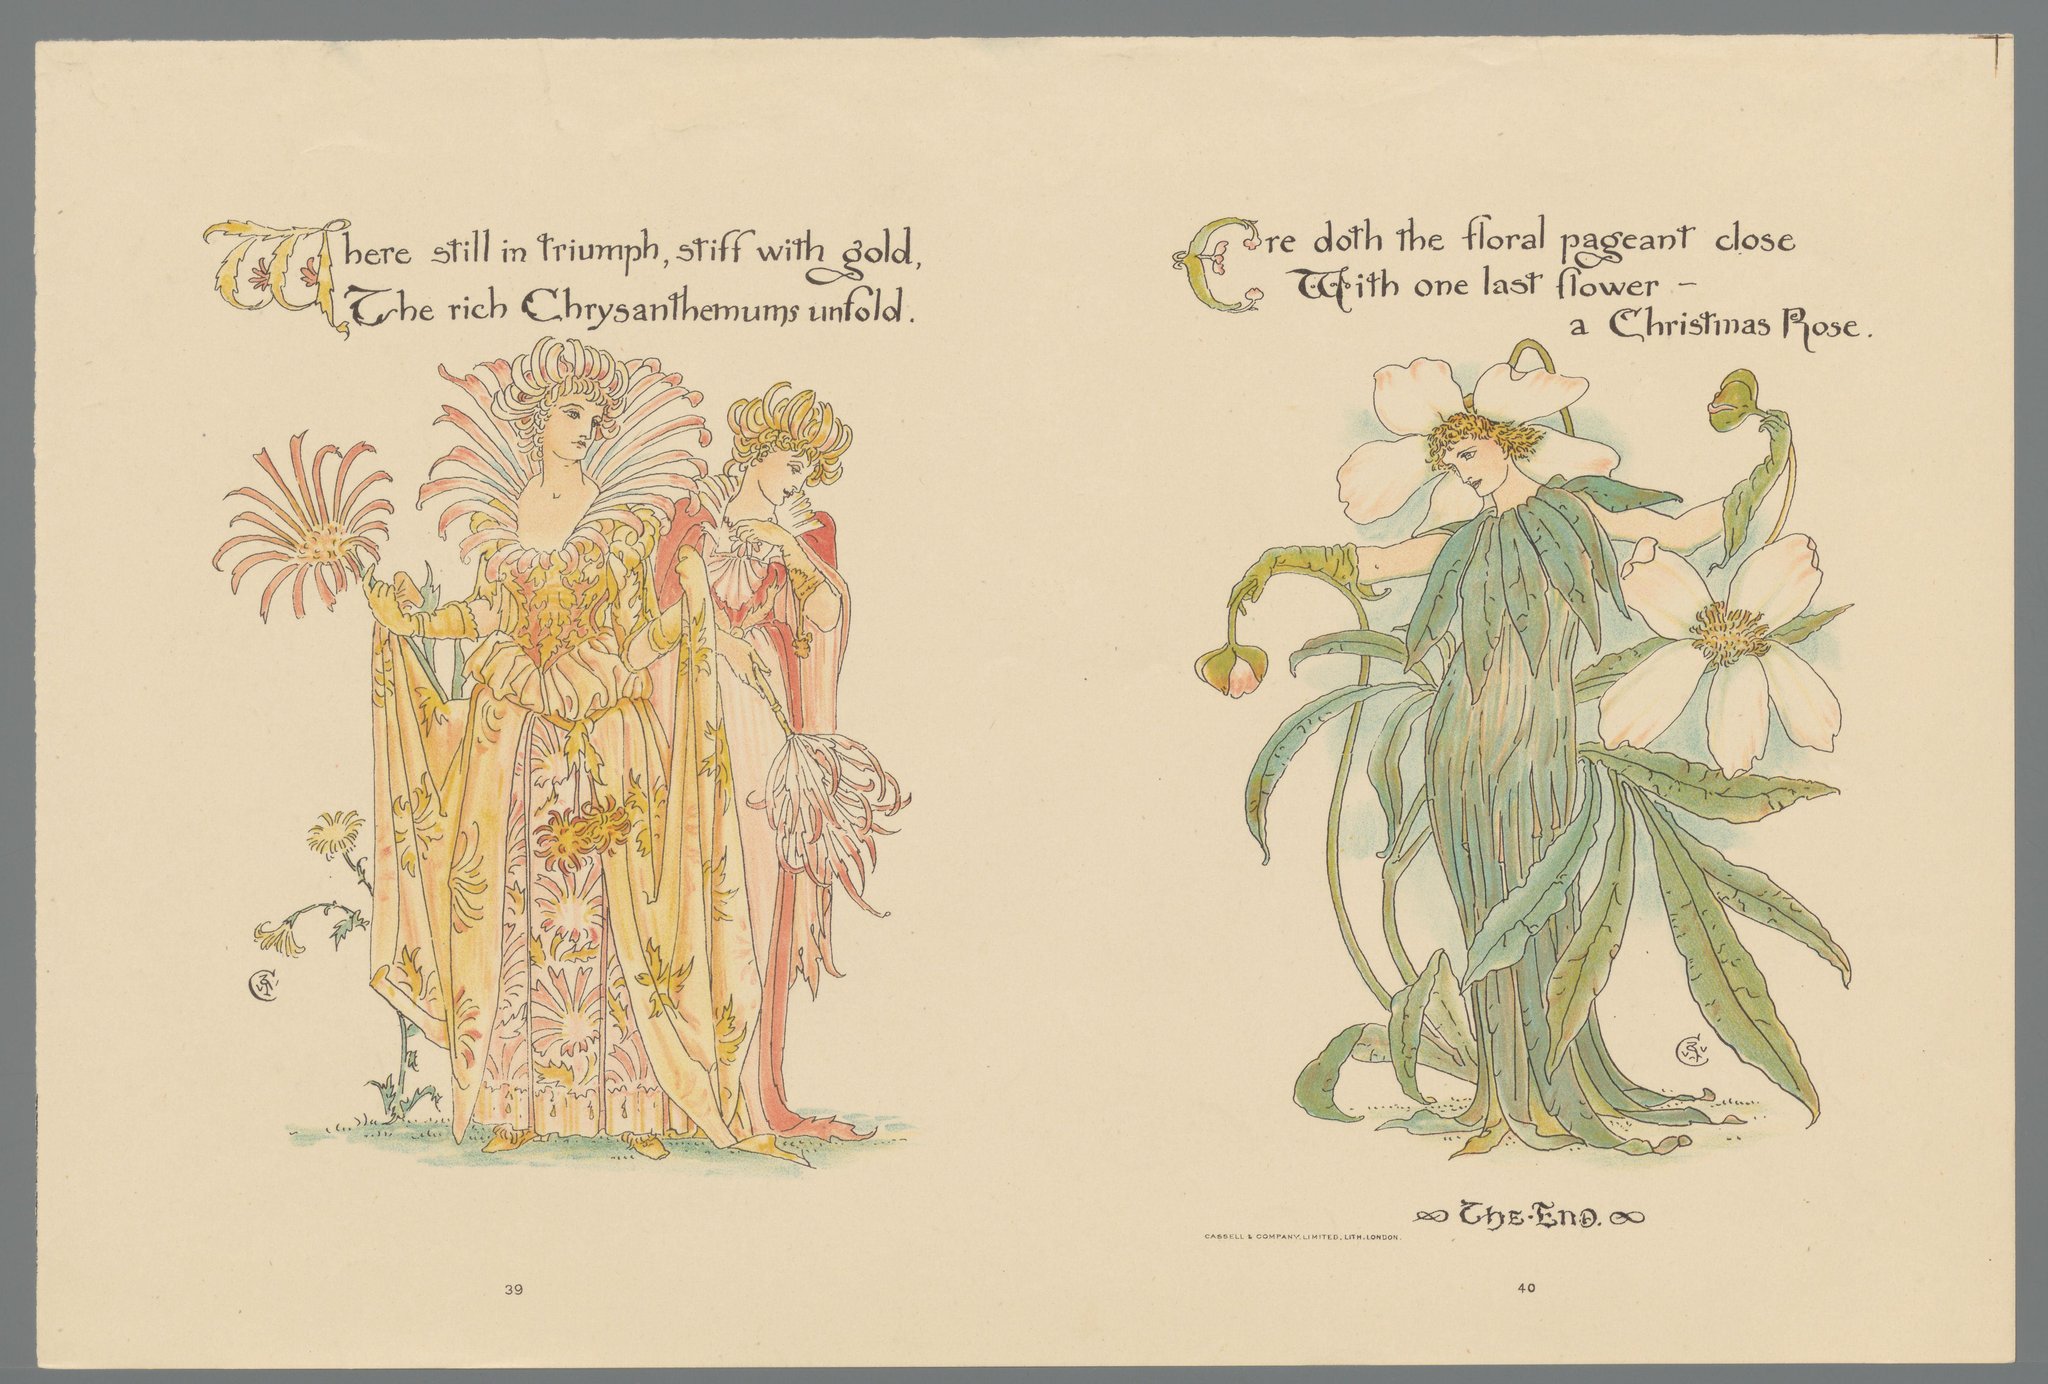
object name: book illustration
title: Drie vrouwen in bloemenkostuum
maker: walter crane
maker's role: draughtsman, print maker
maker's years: 1845-1915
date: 1889-1927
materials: paper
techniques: lithograph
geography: london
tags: flowers, plants behaving as human beings or animals, adult woman (+ three persons)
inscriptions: collector's mark: Lugt 2228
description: Prent uit: Crane, Walter. Flora's Feast, a masque of flowers. Londen: Cassel & Co., 1889. Of een latere uitgave.